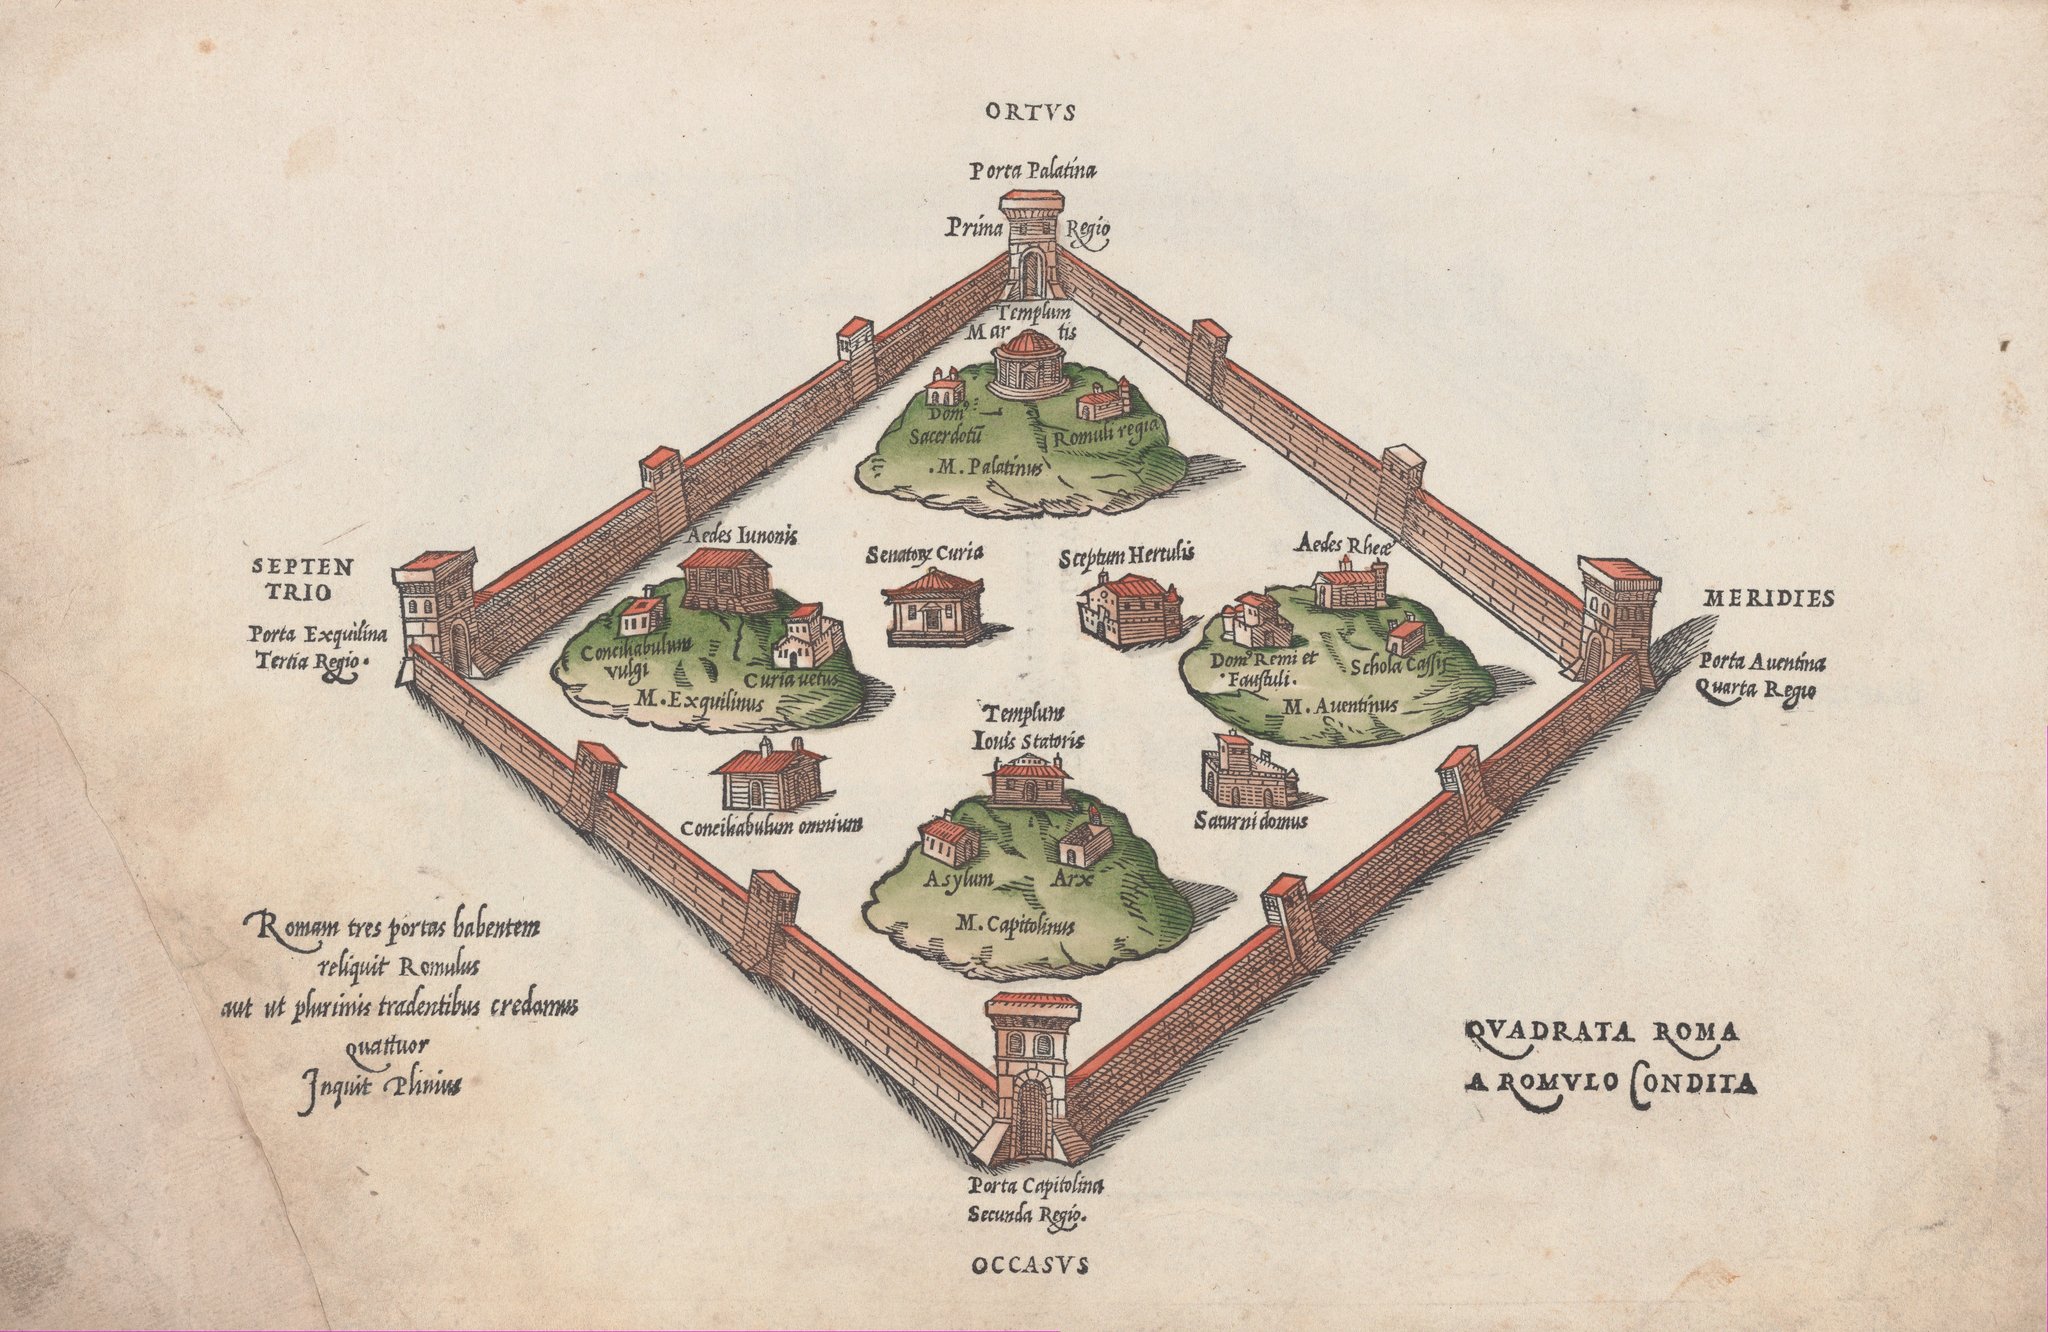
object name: book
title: Antiquae Urbis Romae cum Regionibus Simulacrum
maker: fabio calvo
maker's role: author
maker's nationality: italian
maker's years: 1450-1527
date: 1532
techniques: hand coloring, printing, woodcut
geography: italy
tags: cities